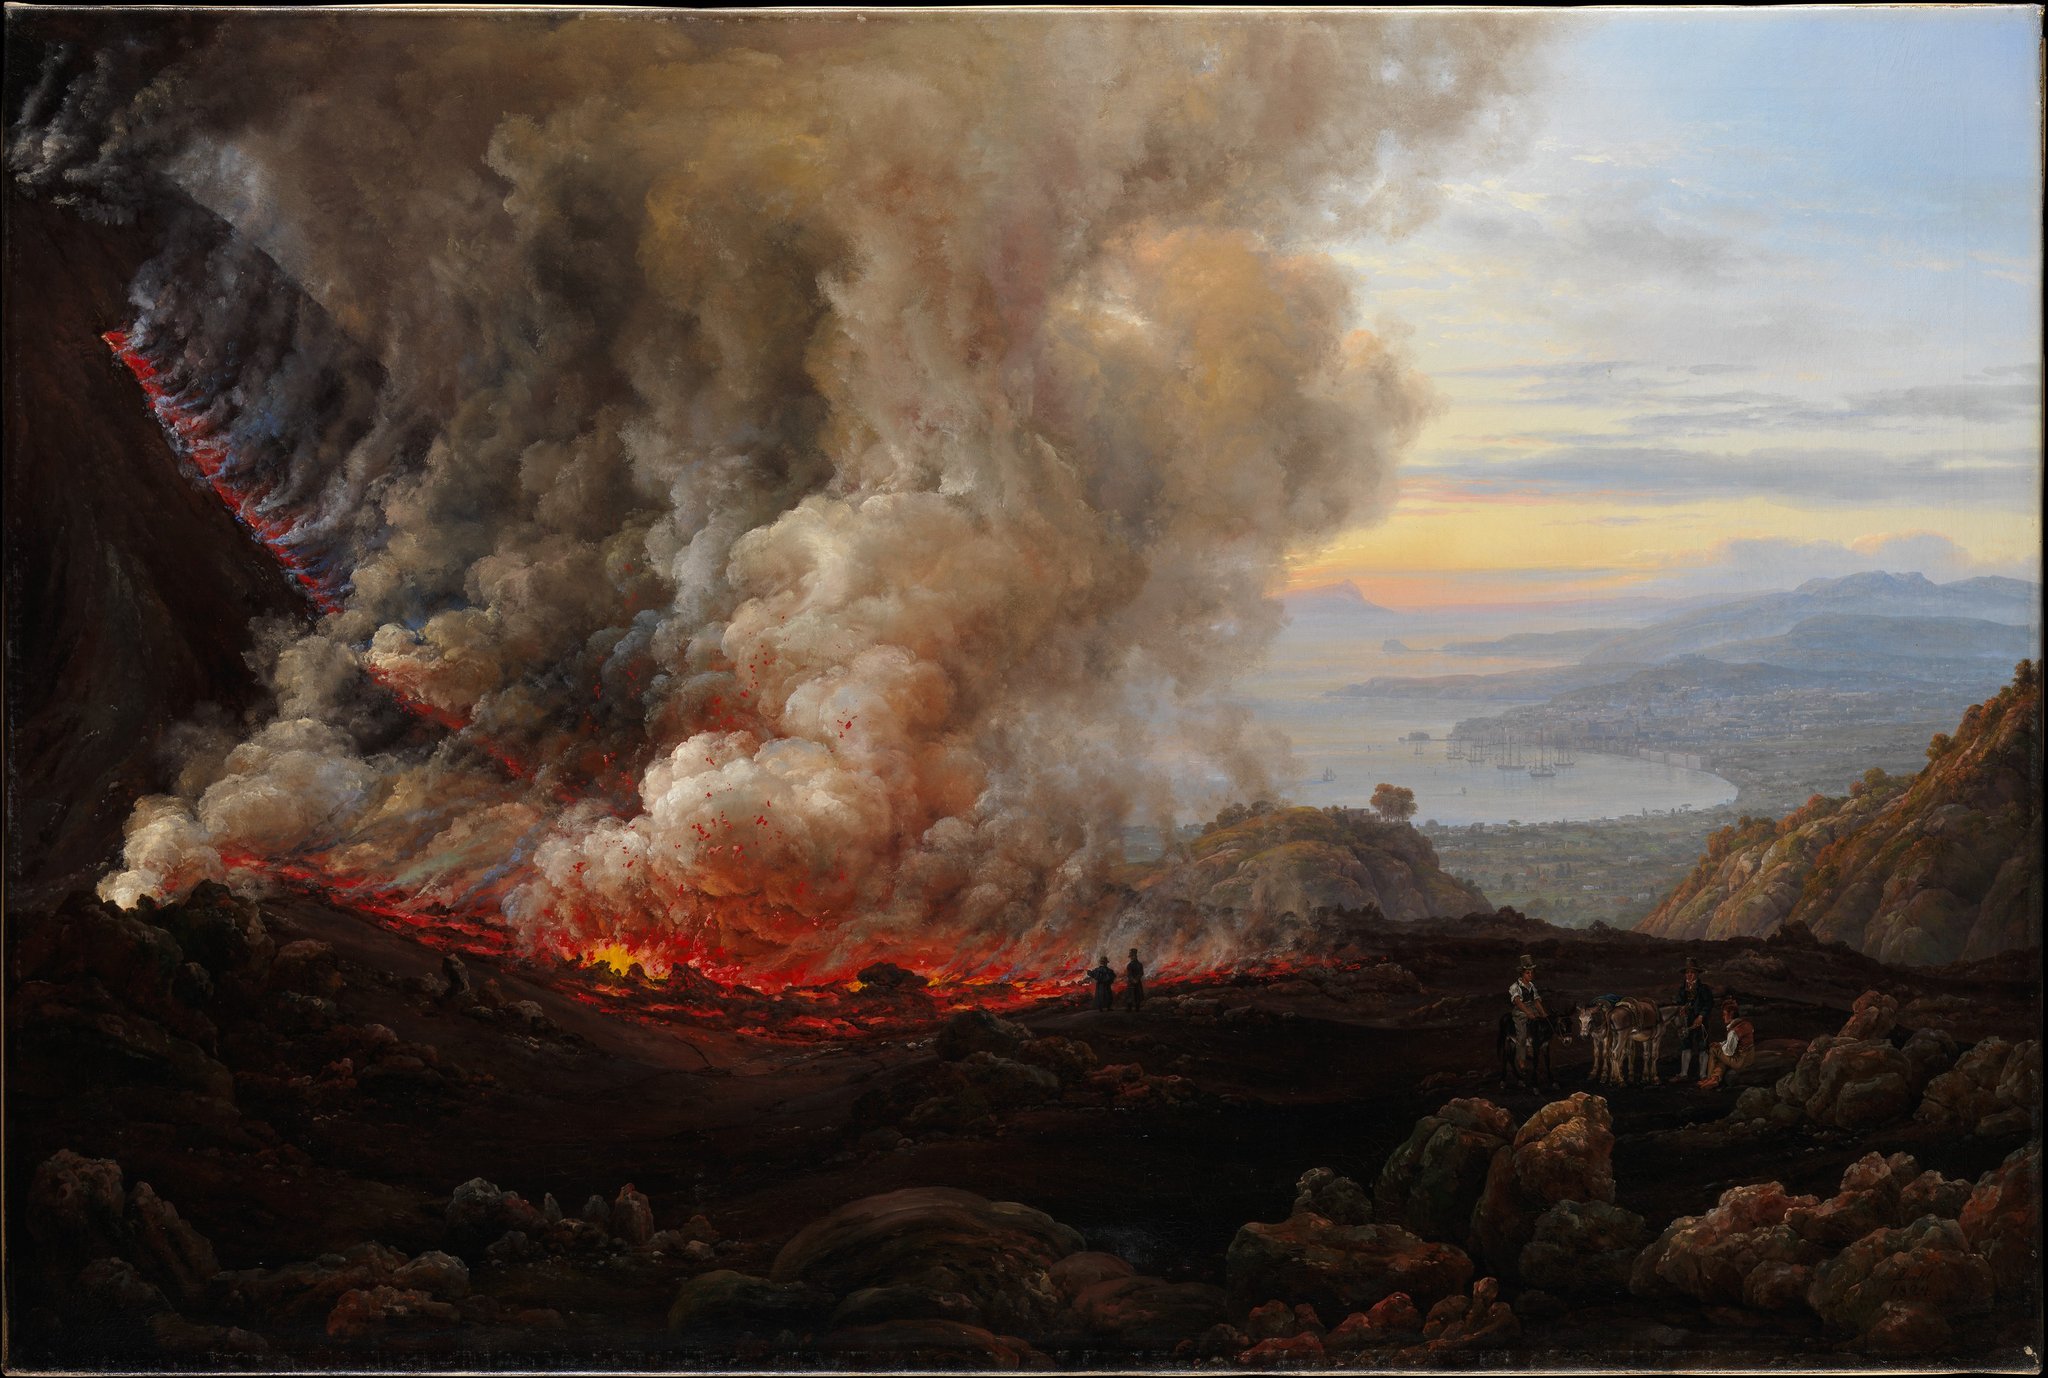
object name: painting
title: An Eruption of Vesuvius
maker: johan christian dahl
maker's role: artist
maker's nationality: norwegian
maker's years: 1788-1857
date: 1824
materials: canvas, oil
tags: donkeys,fire,mountains,volcanoes